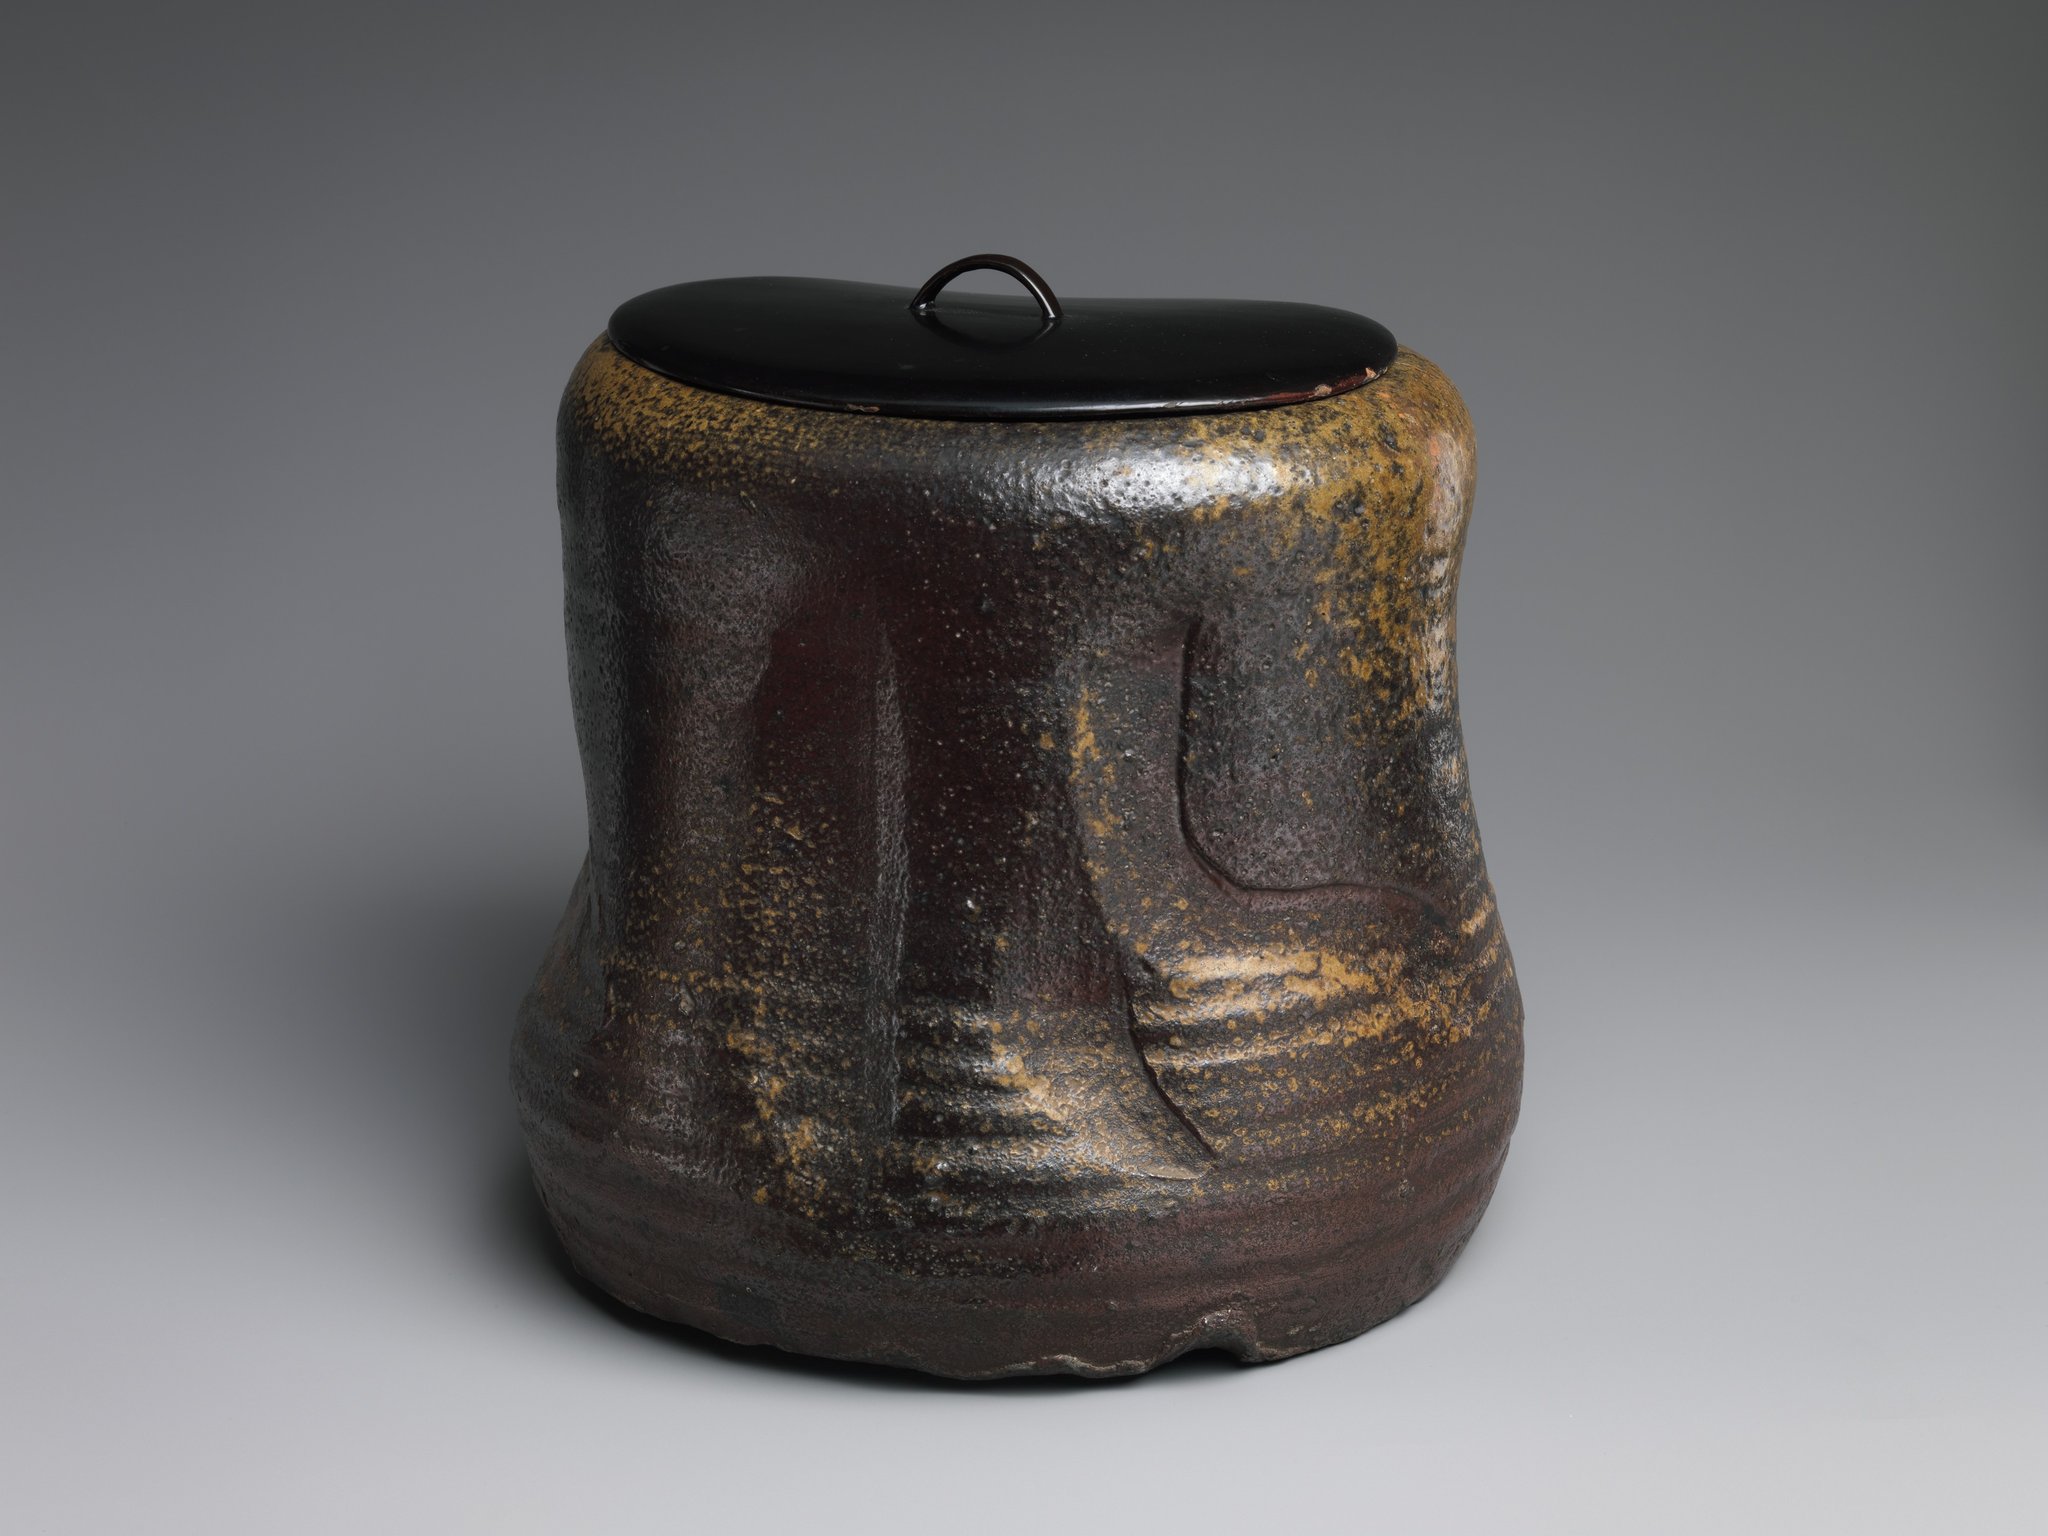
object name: water pot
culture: japanese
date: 1625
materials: lacquer, pottery